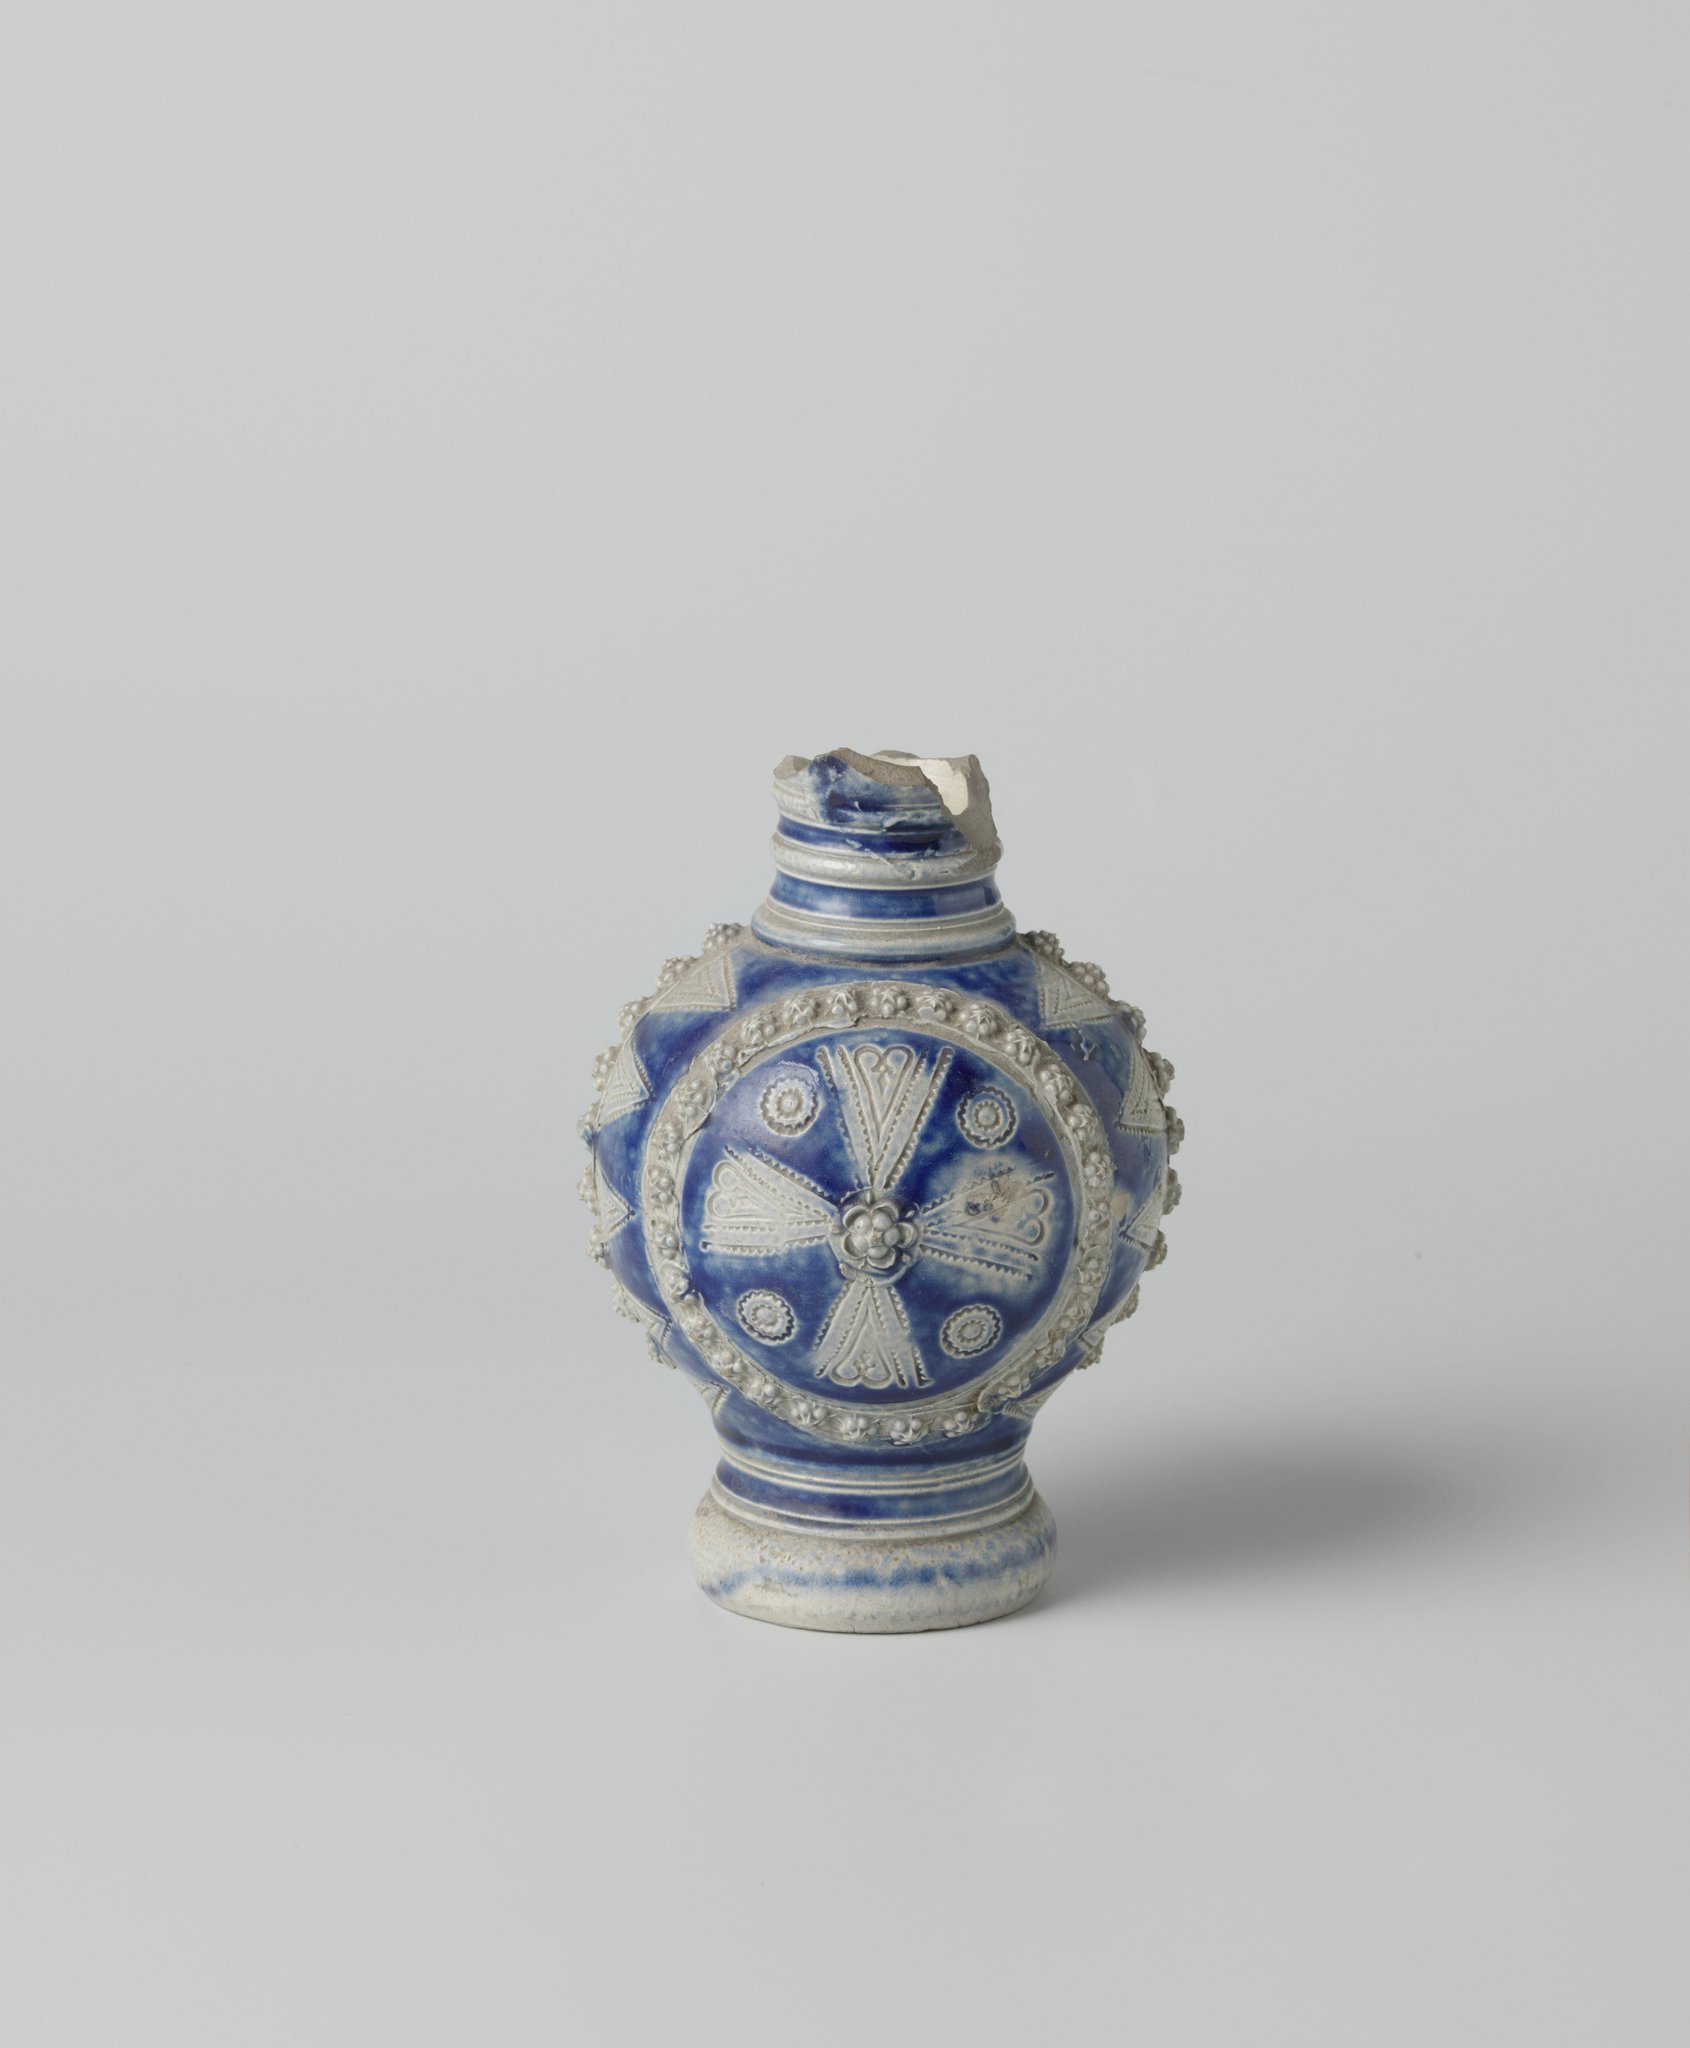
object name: fragment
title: Fragment of a jug with roundels and stylized foliate ornaments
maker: Anonymous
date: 1600-1699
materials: cobalt, glaze, stoneware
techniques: printing, firing, forming, relief, turning, vitrification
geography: westerwald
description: Fragment van een kan van steengoed op hoge voet met een bolvormig lichaam en smalle nek. Een deel van de nek en het oor ontbreken. Profielen op de nek en voet. Gedeeltelijk bedekt met kobaltblauw. Op de buik in reliëf een gedrukte en opgelegde cirkel van rozetten. In het centrum een rozet, omringd door gestempelde cirkels en gestileerde bladmotieven. De zijkant met een verticale band rozetten met aan weerszijden driehoekige bladmotieven. Westerwald.